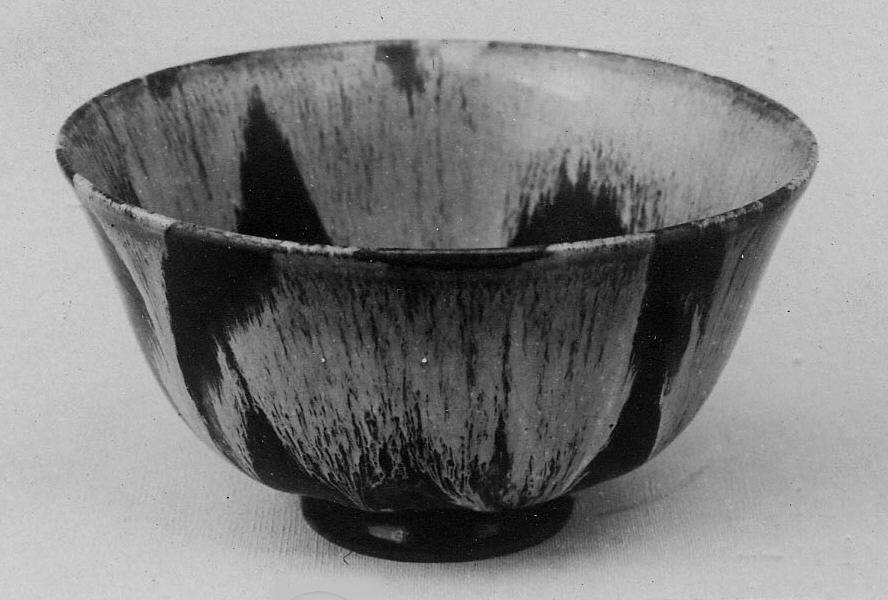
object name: cup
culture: japanese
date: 1700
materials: glaze